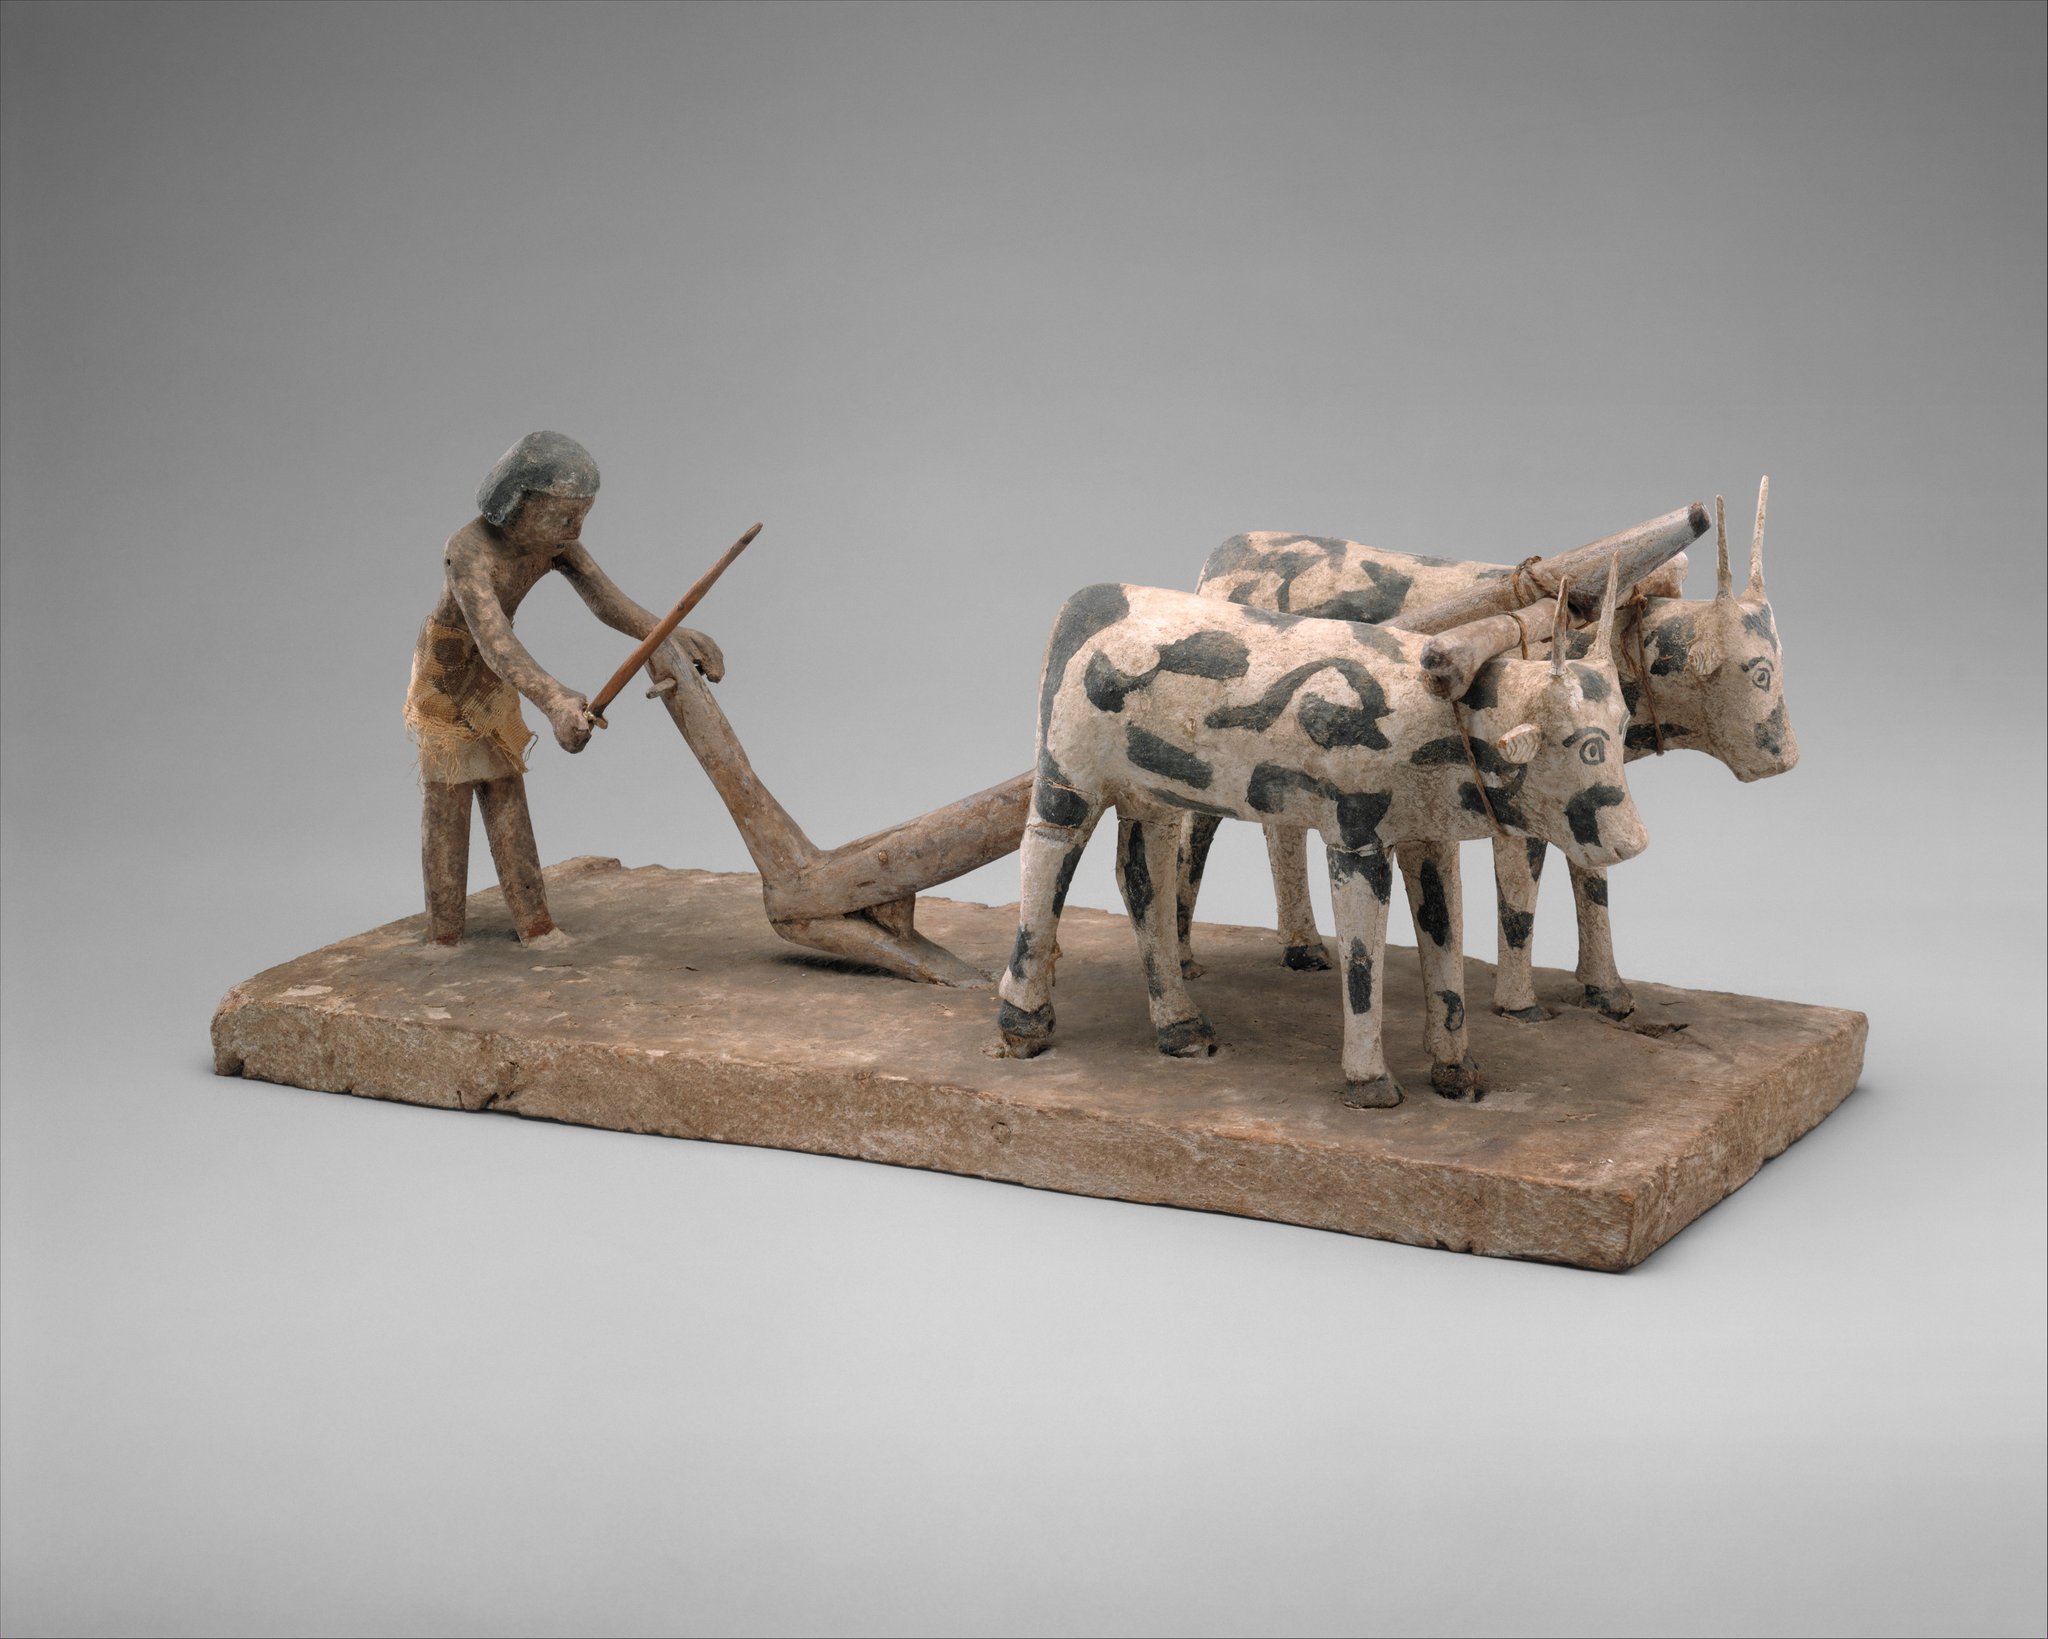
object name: model, plowing, cattle, cow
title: Model of a Man Plowing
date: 1981-1885 BCE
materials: wood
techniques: painting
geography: egypt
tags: men,working,ox